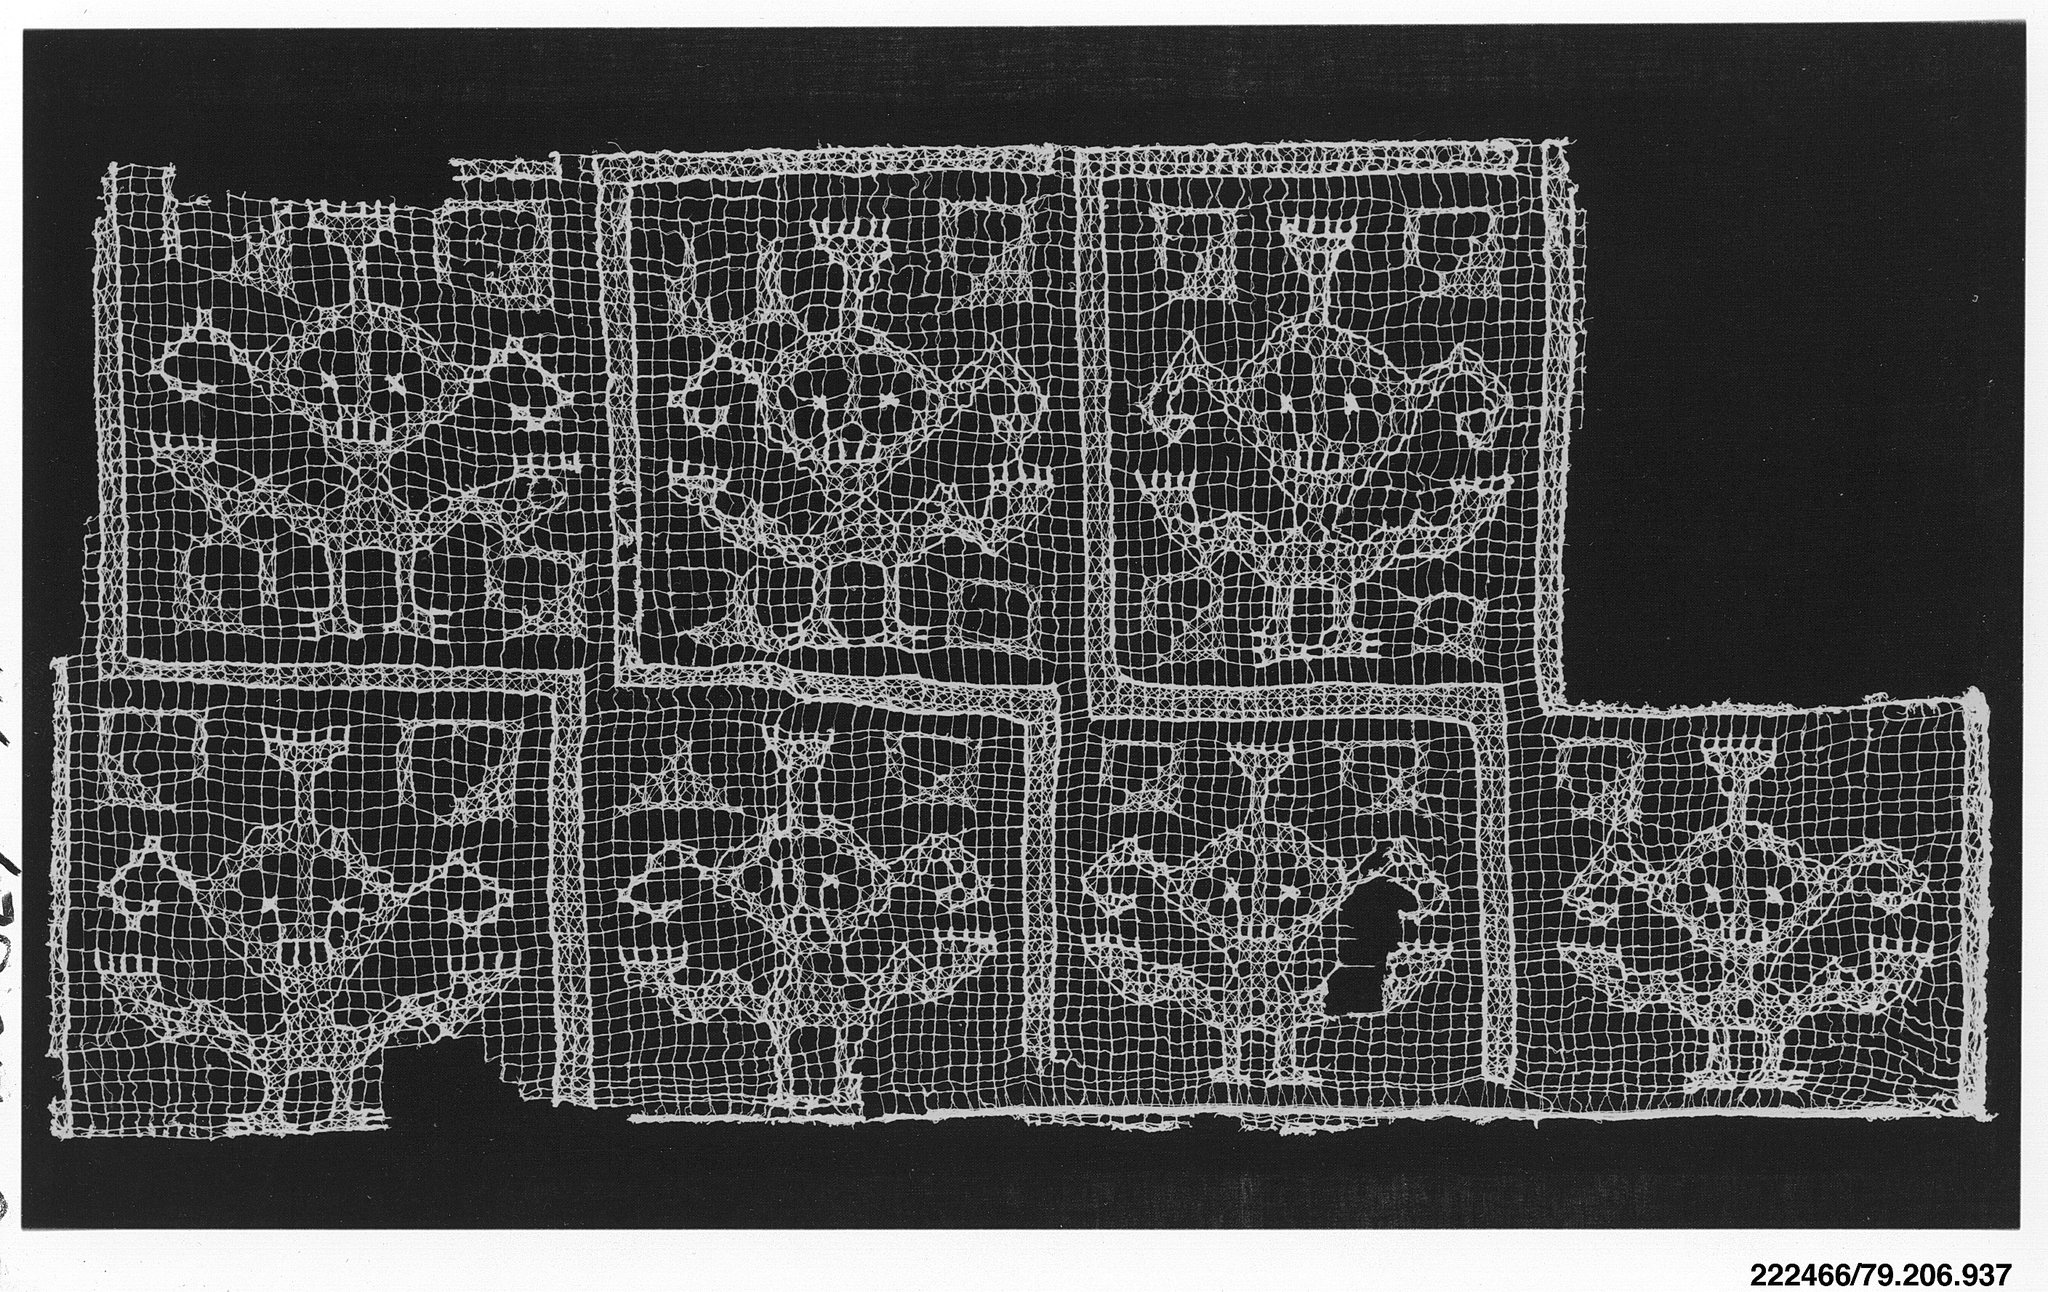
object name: headband fragment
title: Openwork Headband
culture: chancay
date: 1101-1500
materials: cotton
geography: peru